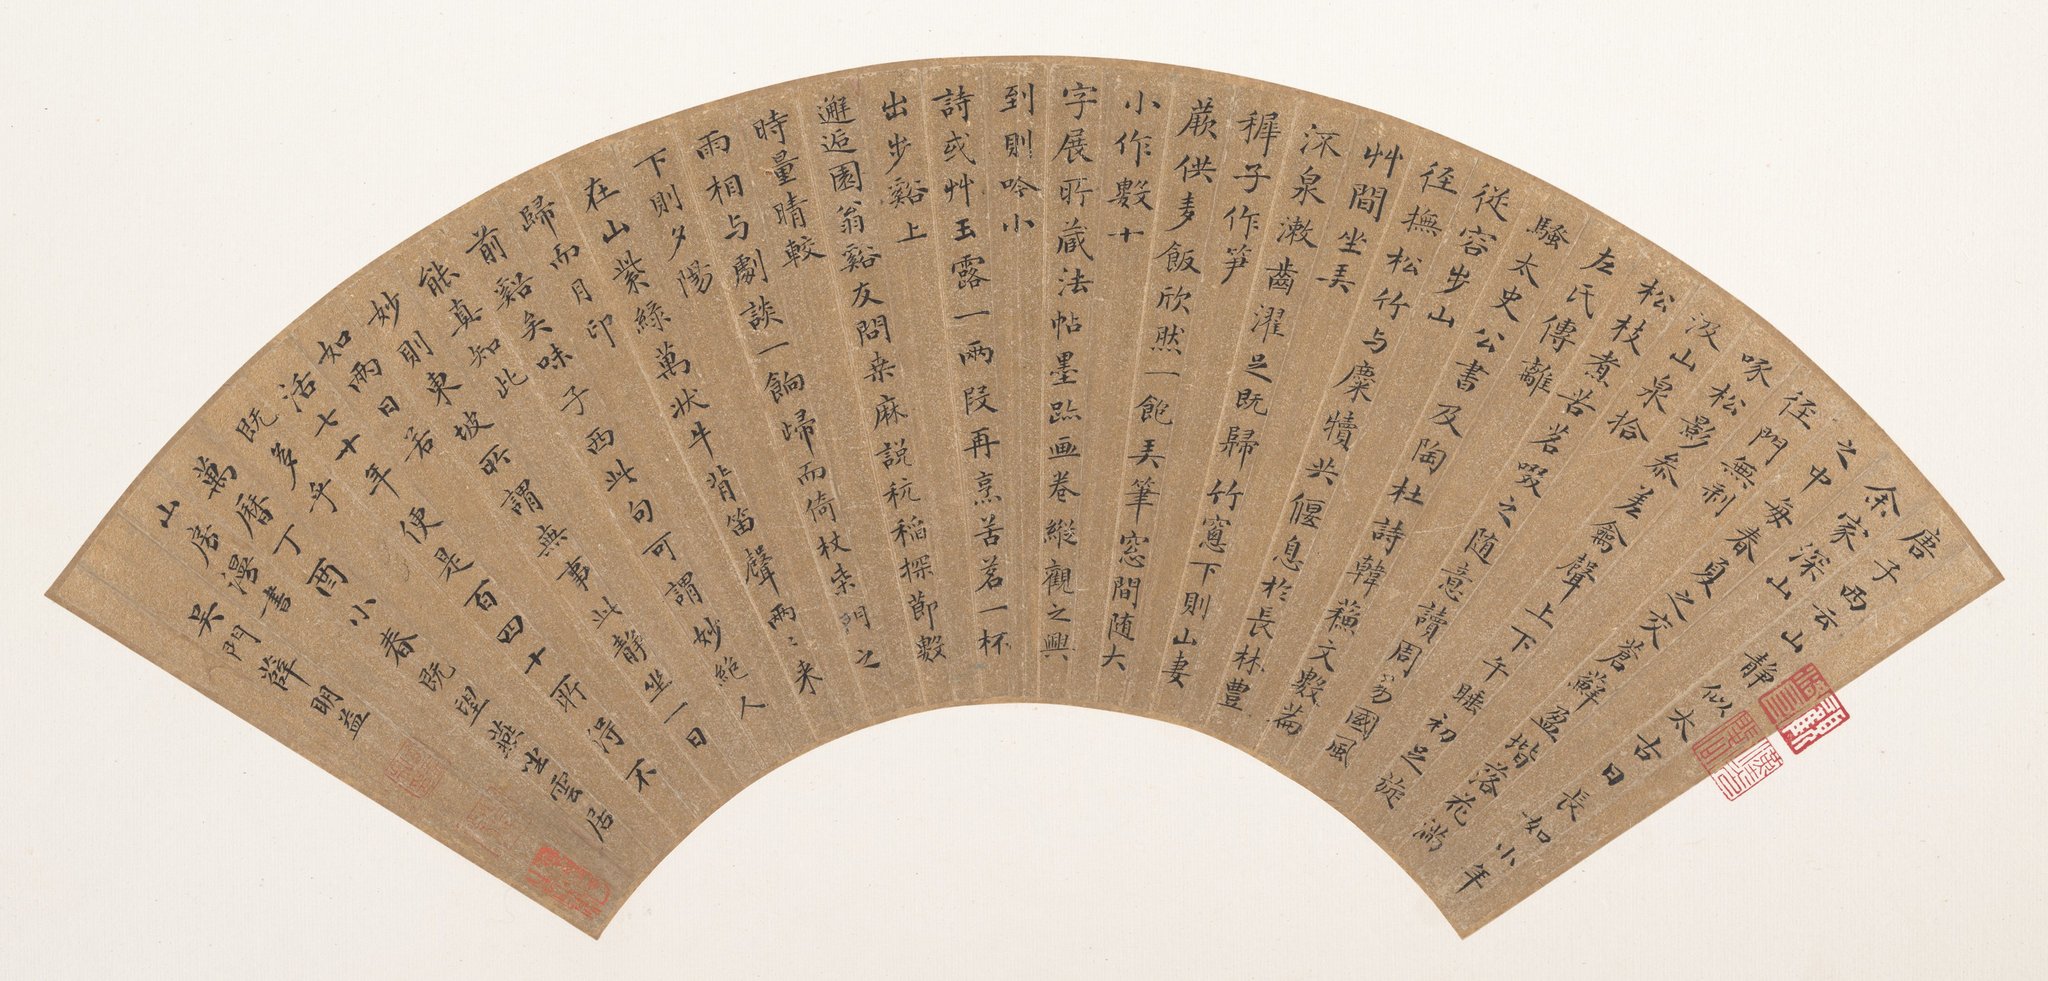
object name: folding fan mounted a an album leaf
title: Letter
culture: chinese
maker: xue mingyi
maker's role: artist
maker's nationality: chinese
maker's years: 1538-1598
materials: gold, ink, paper